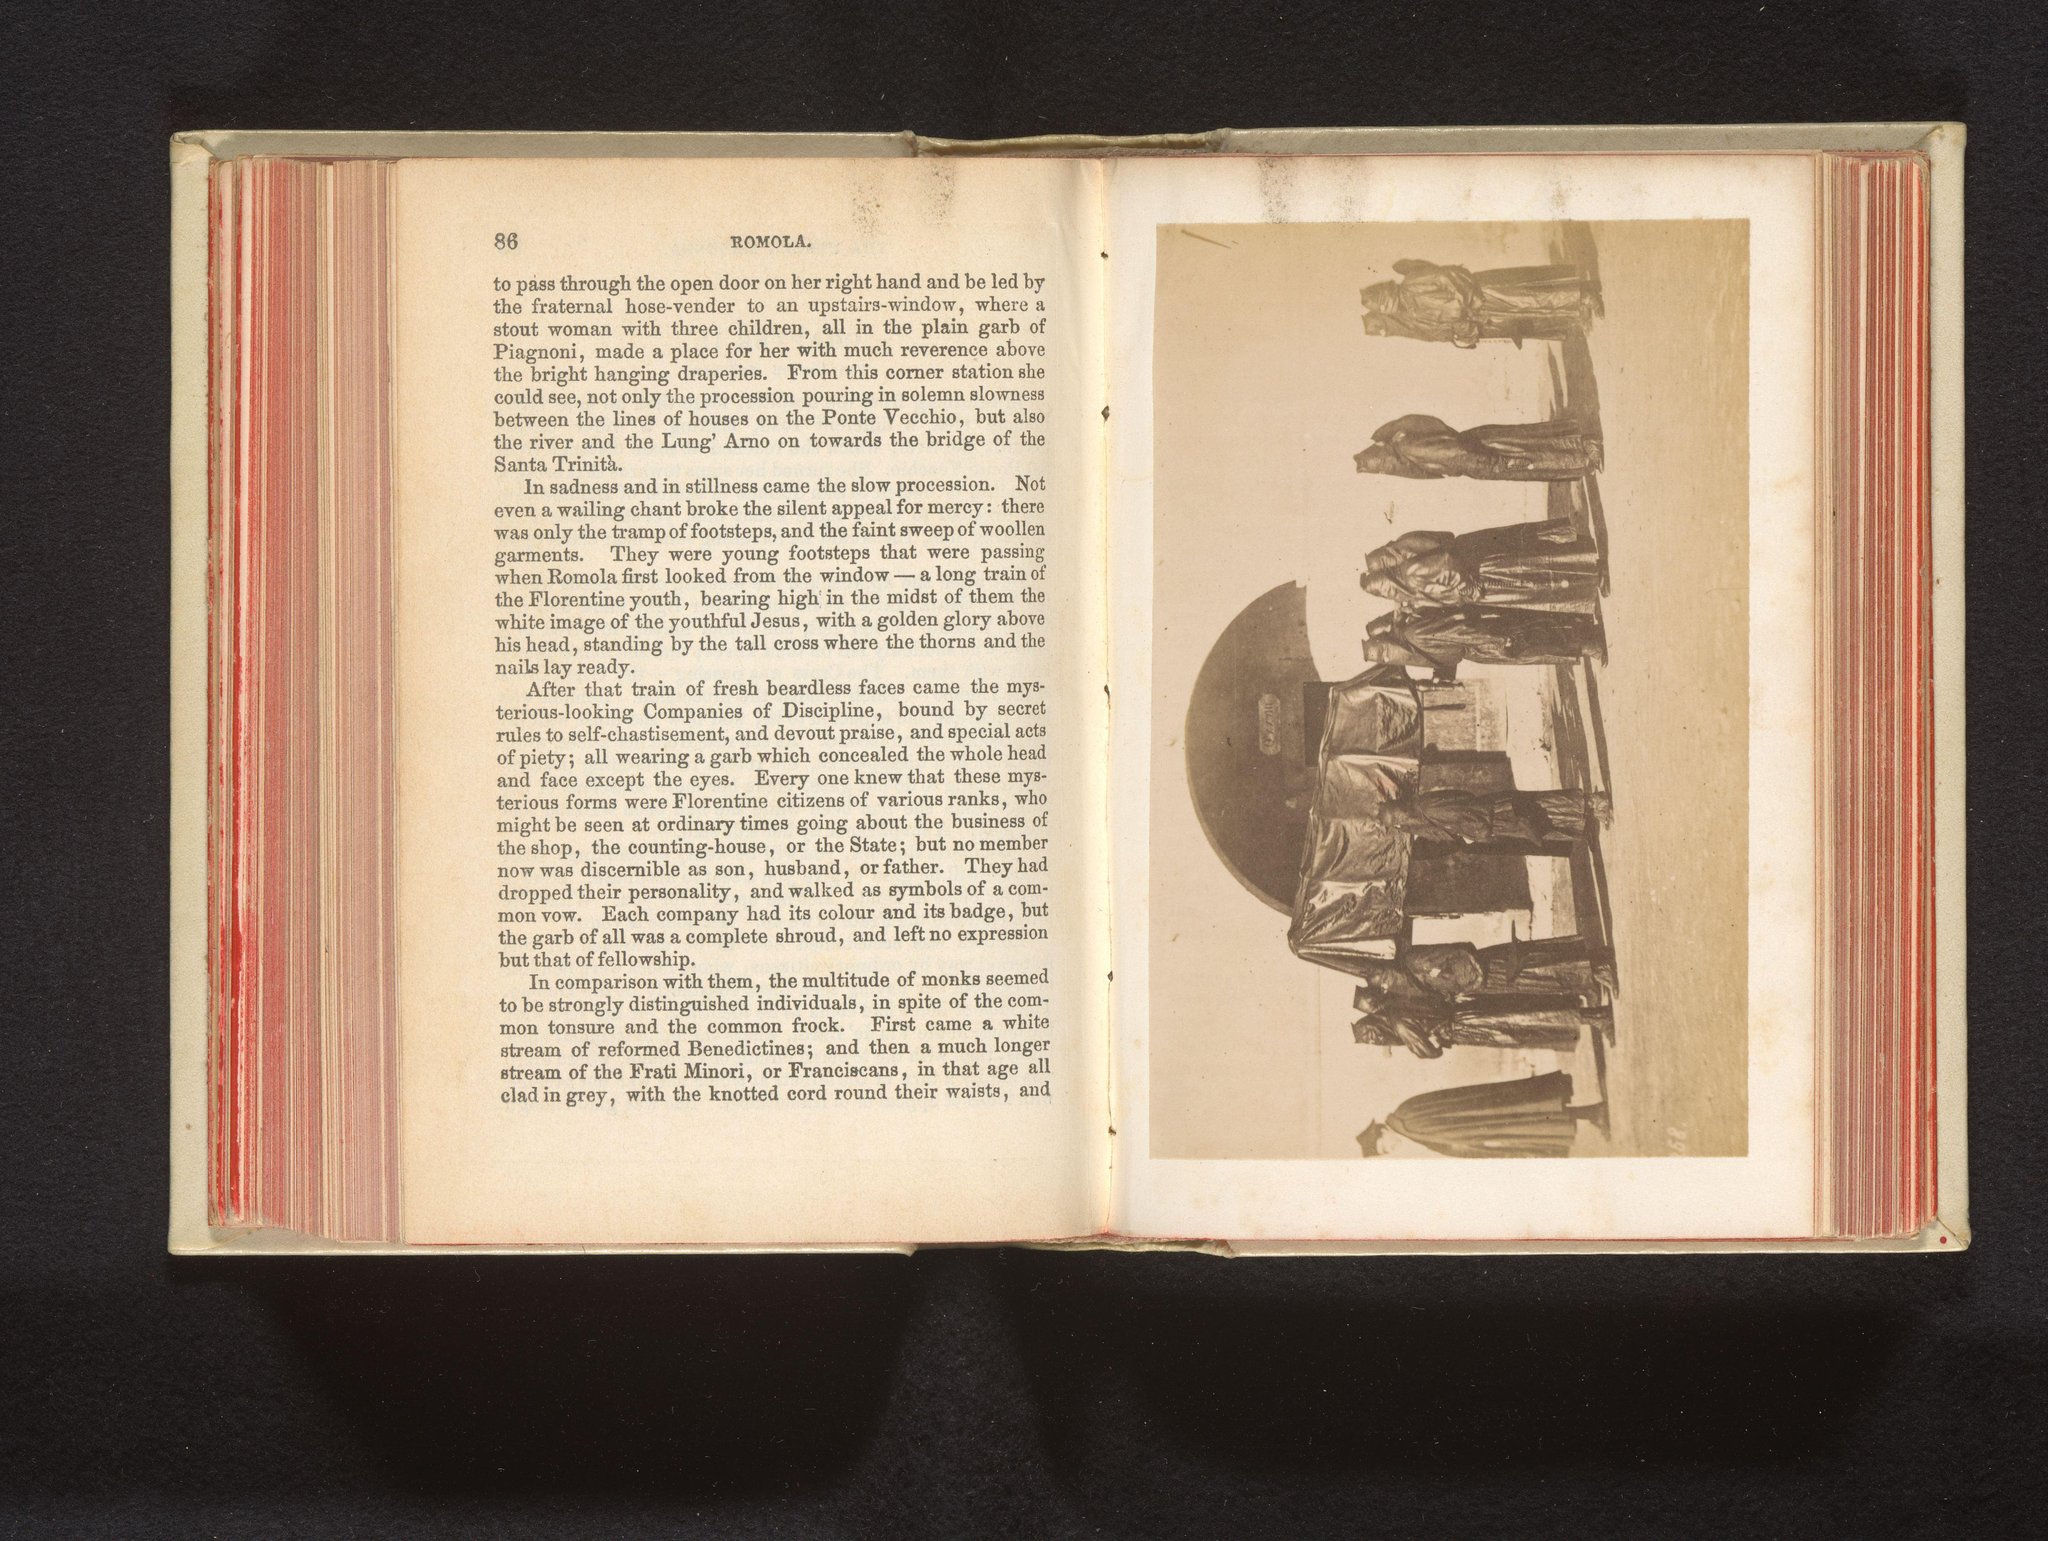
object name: page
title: Begrafenisstoet te Florence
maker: Anonymous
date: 1858-1863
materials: photographic support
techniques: albumen print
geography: florence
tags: cortege, funeral procession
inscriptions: number: ‘[...]68.’